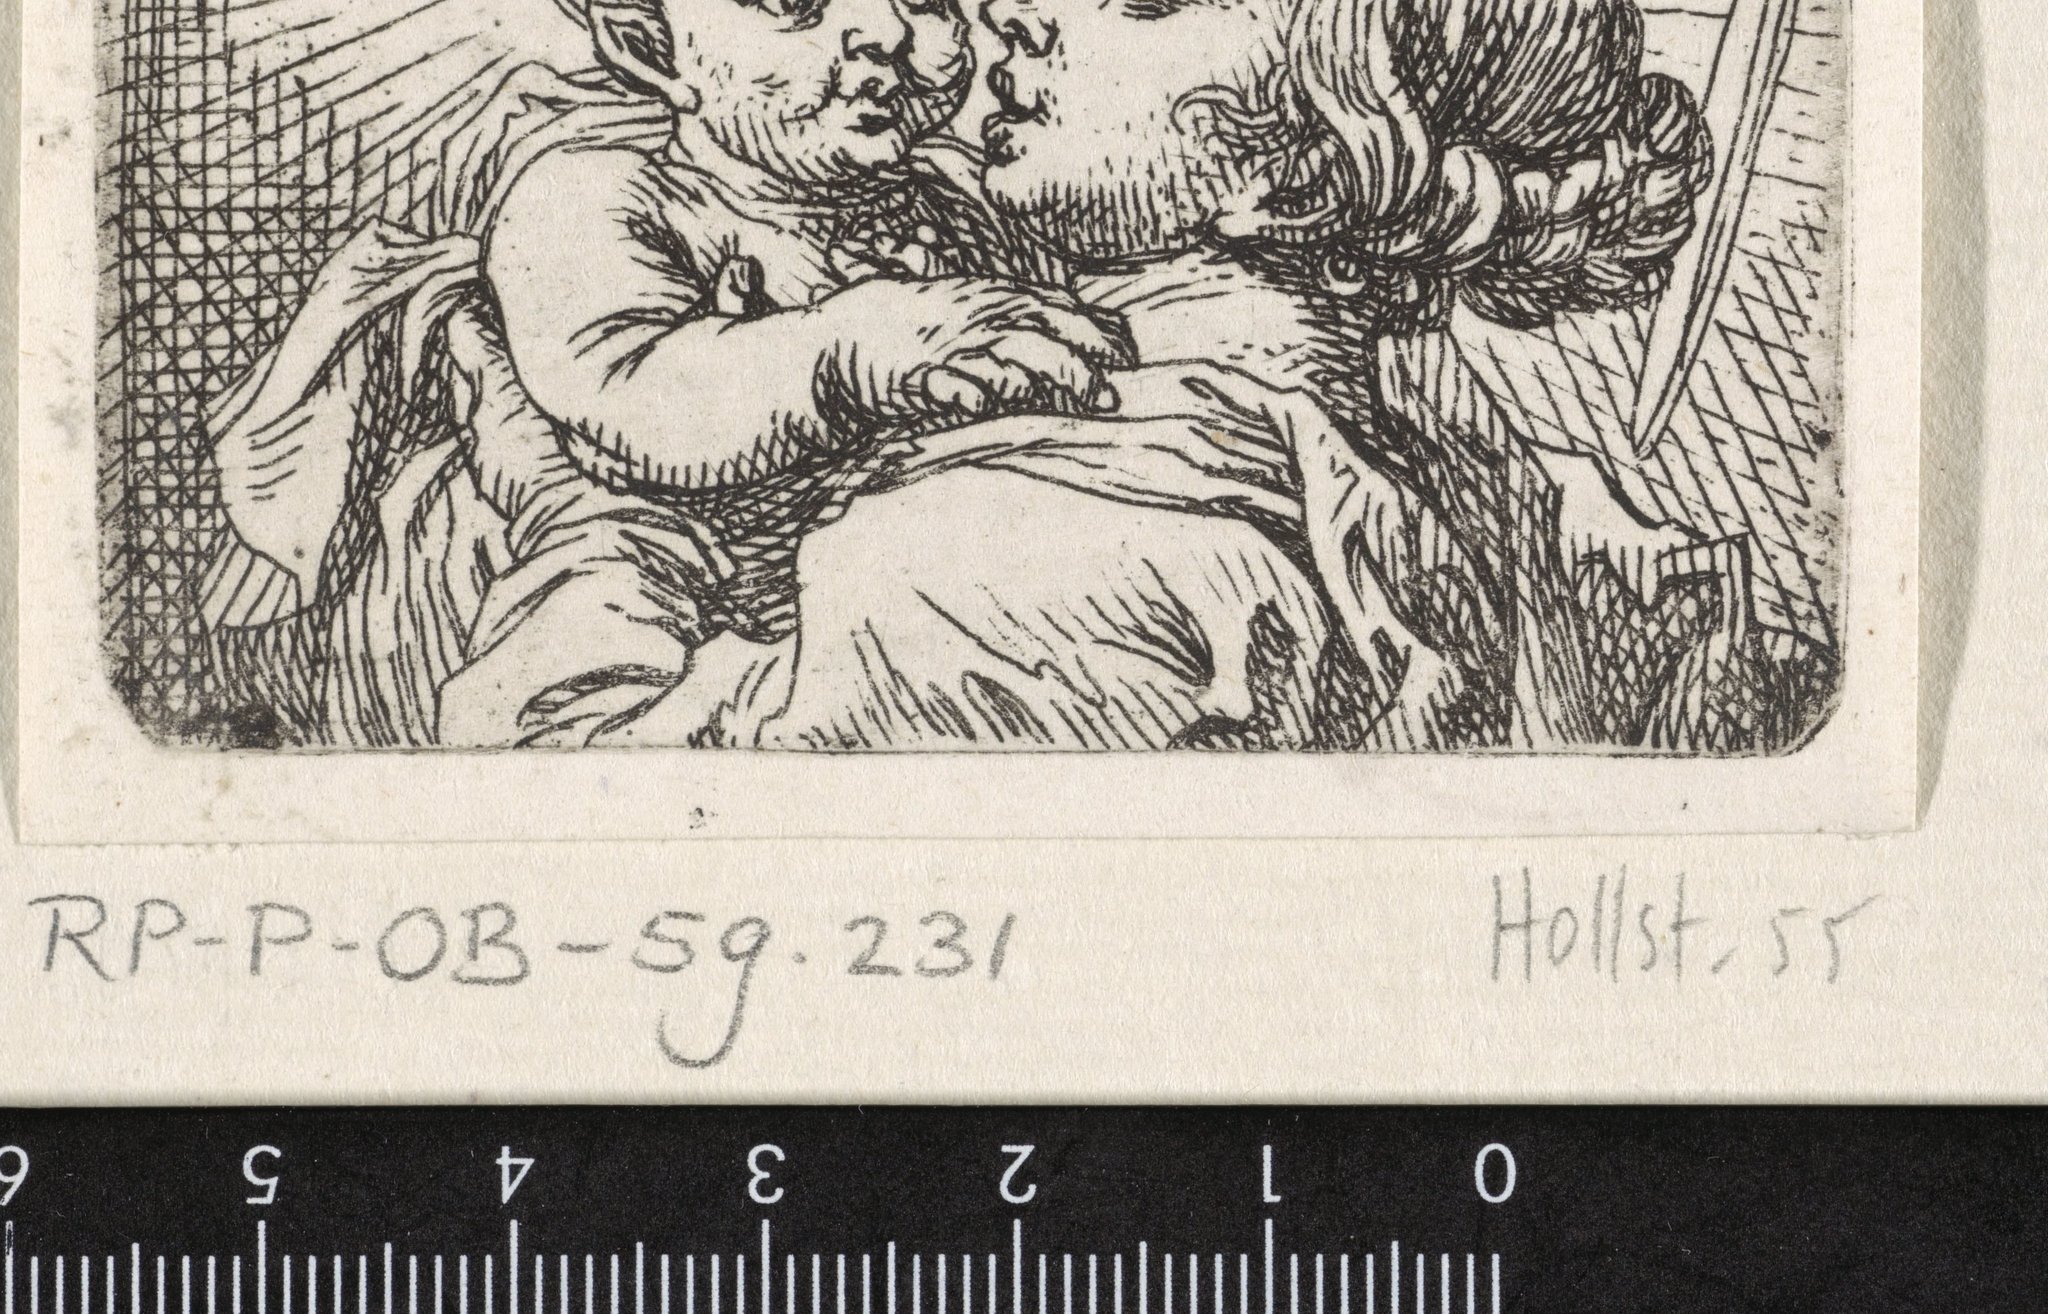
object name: print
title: Madonna met kind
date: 1618-1655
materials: paper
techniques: etching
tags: madonna: i.e. mary with the christ-child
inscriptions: collector's mark: Lugt 240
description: Maria houdt het Christuskind tegen haar borst. Hij houdt zijn hand op haar schouder.